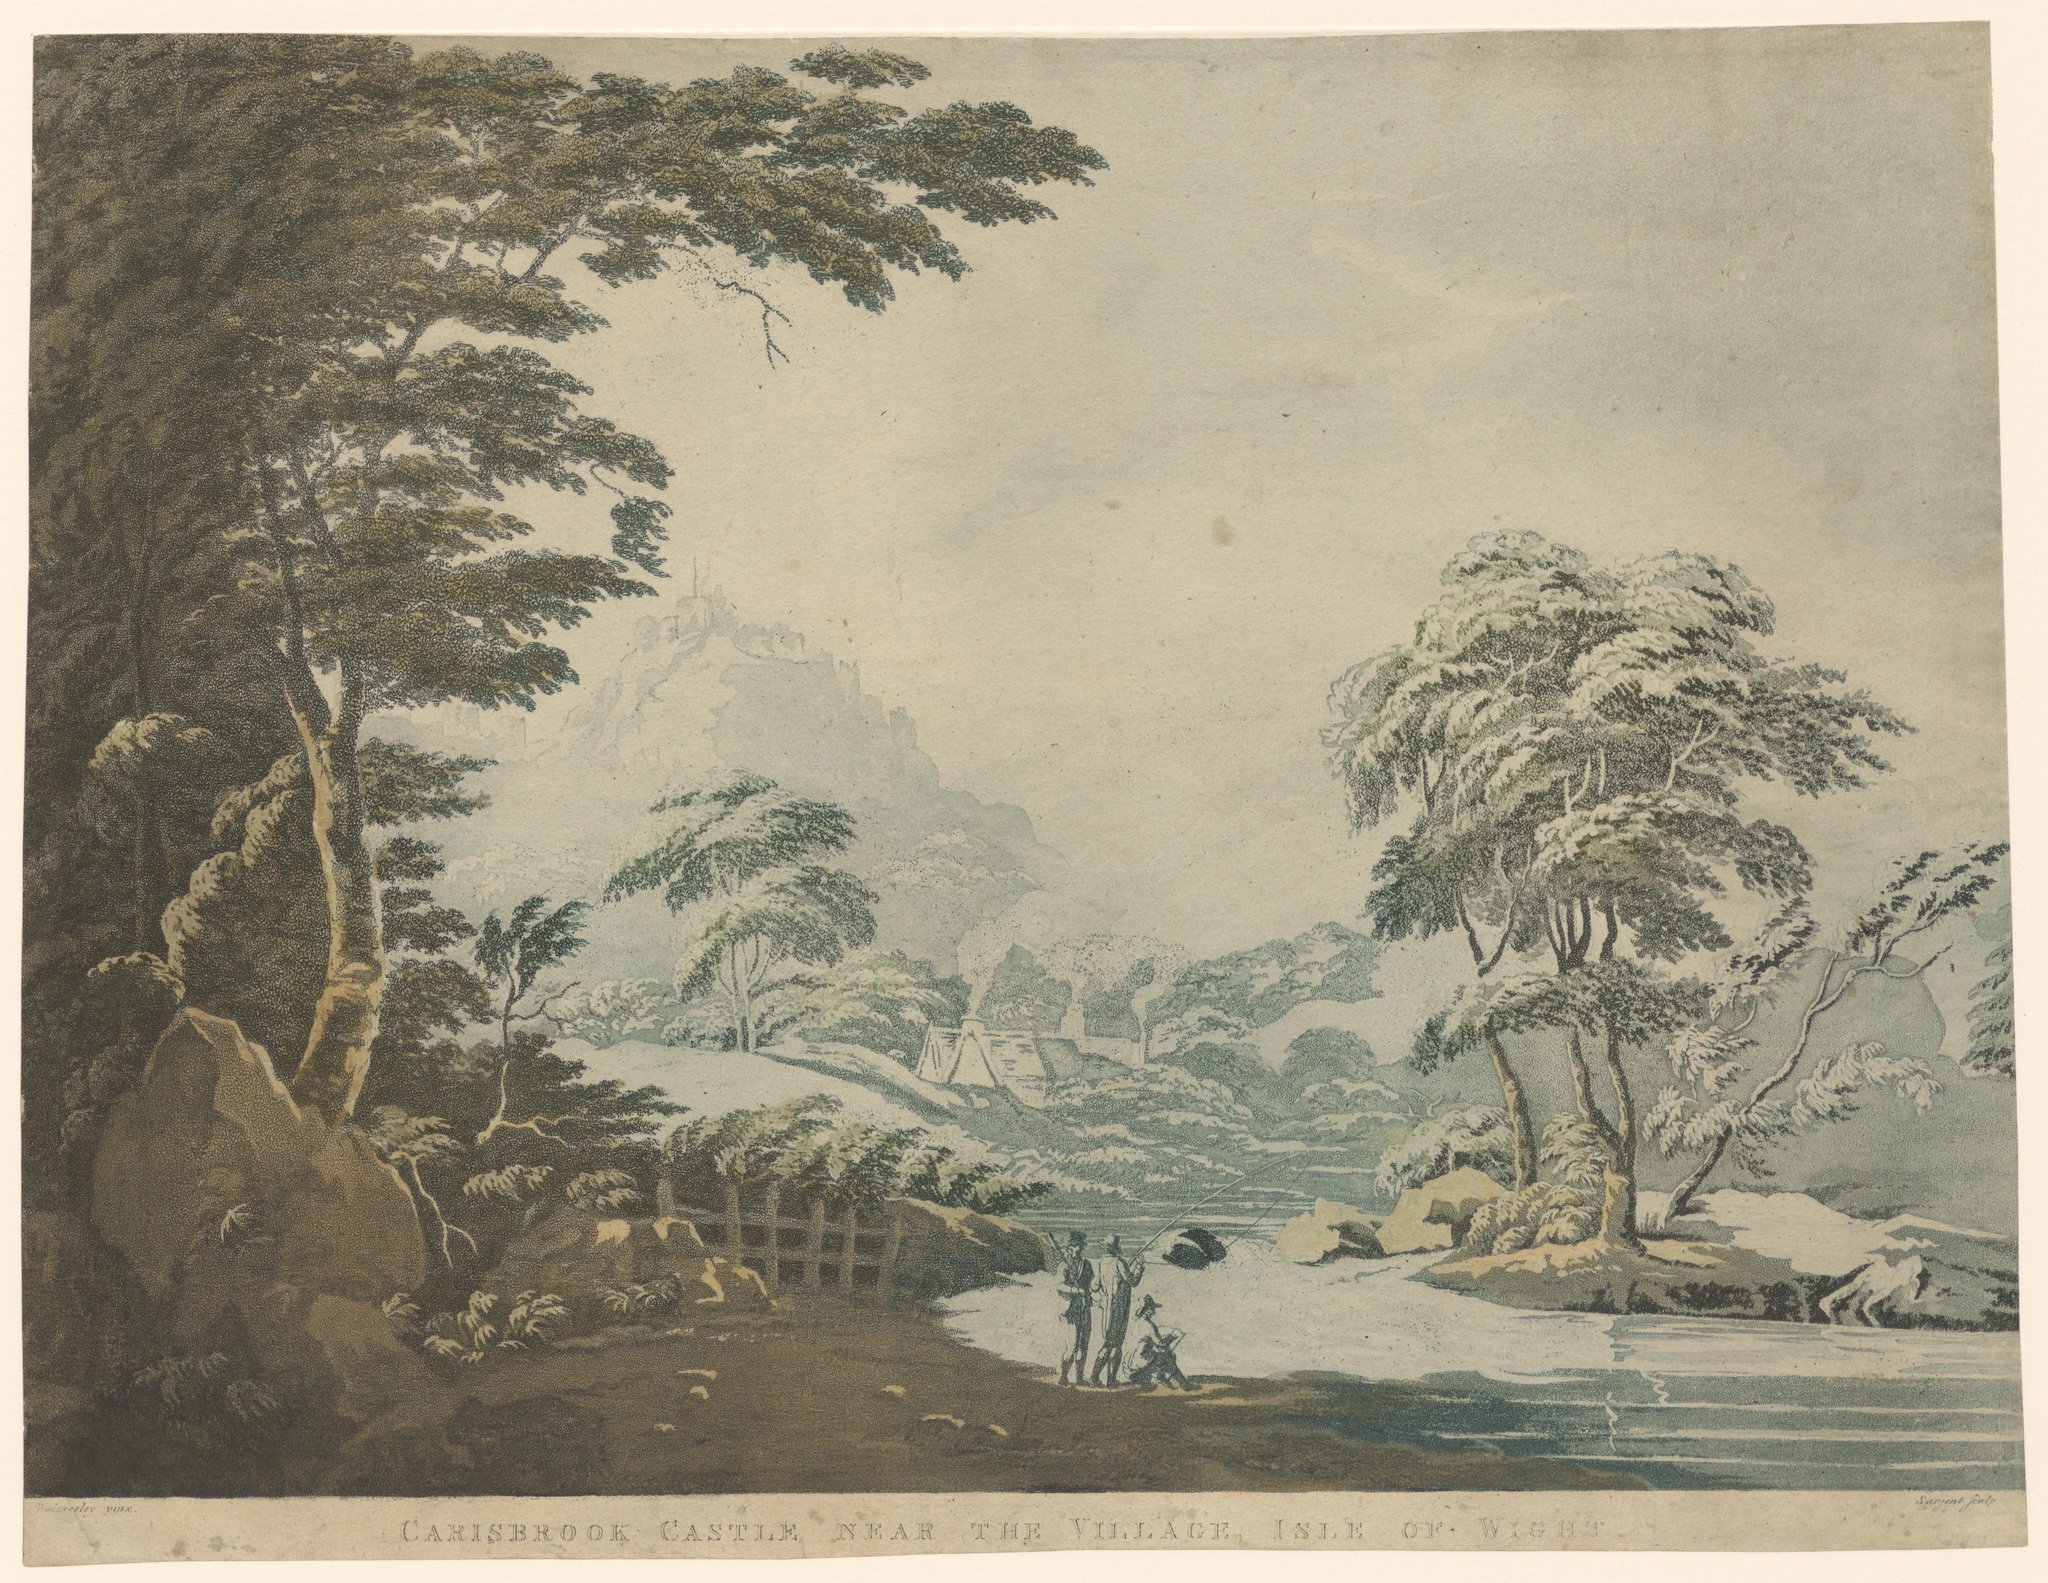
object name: print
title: Carisbrook Castle near the Village, Isle of Wight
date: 1790-1812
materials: paper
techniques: hand coloring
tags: fortress, island, isle of wight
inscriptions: collector's mark: Lugt 2228